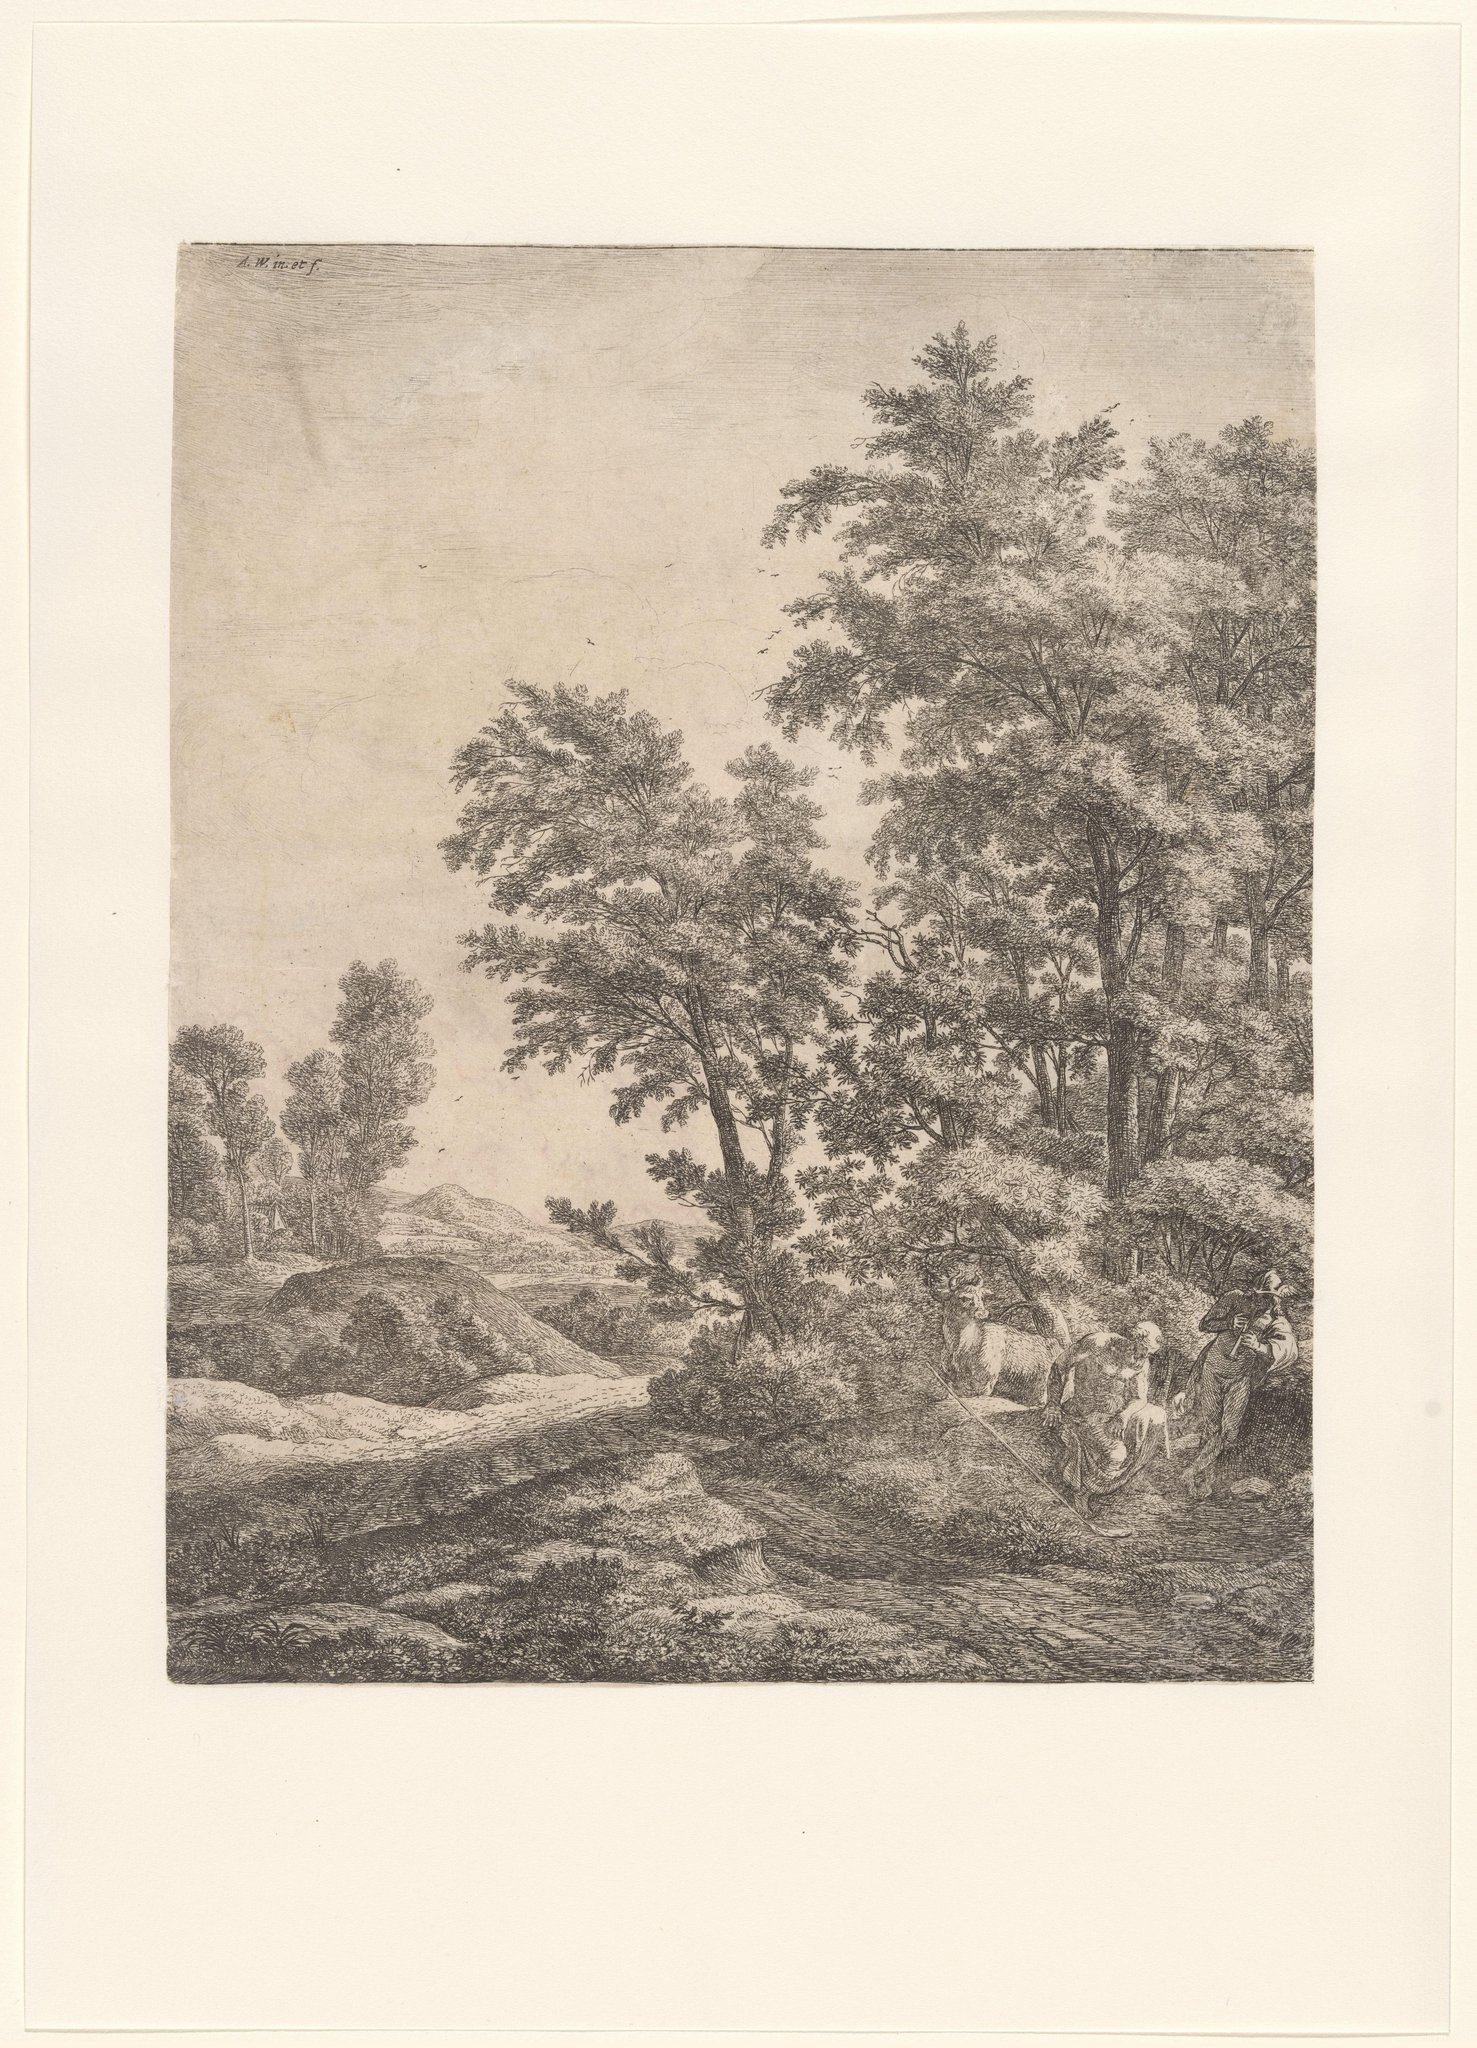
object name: print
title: Mercurius en Argus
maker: anthonie waterloo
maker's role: draughtsman, painter, print maker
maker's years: 1609-1690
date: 1630-1663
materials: paper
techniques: etching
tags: low hill country, mercury lulls argus into sleep by making music, forest, wood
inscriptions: inscription: ‘op de kortte prin[...]/ tusse de een hoor[...]/ bove de boijer/ op een kamer./ Jan Coenra[...]/ Stierma[...]’, collector's mark: Lugt 2228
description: In een bos bespeelt Mercurius zijn herdersfluit om Argus, die tegenover hem zit, in slaap te sussen. Naast Mercurius ligt zijn staf. Schuin achter Argus staat Io in de gedaante van een koe.